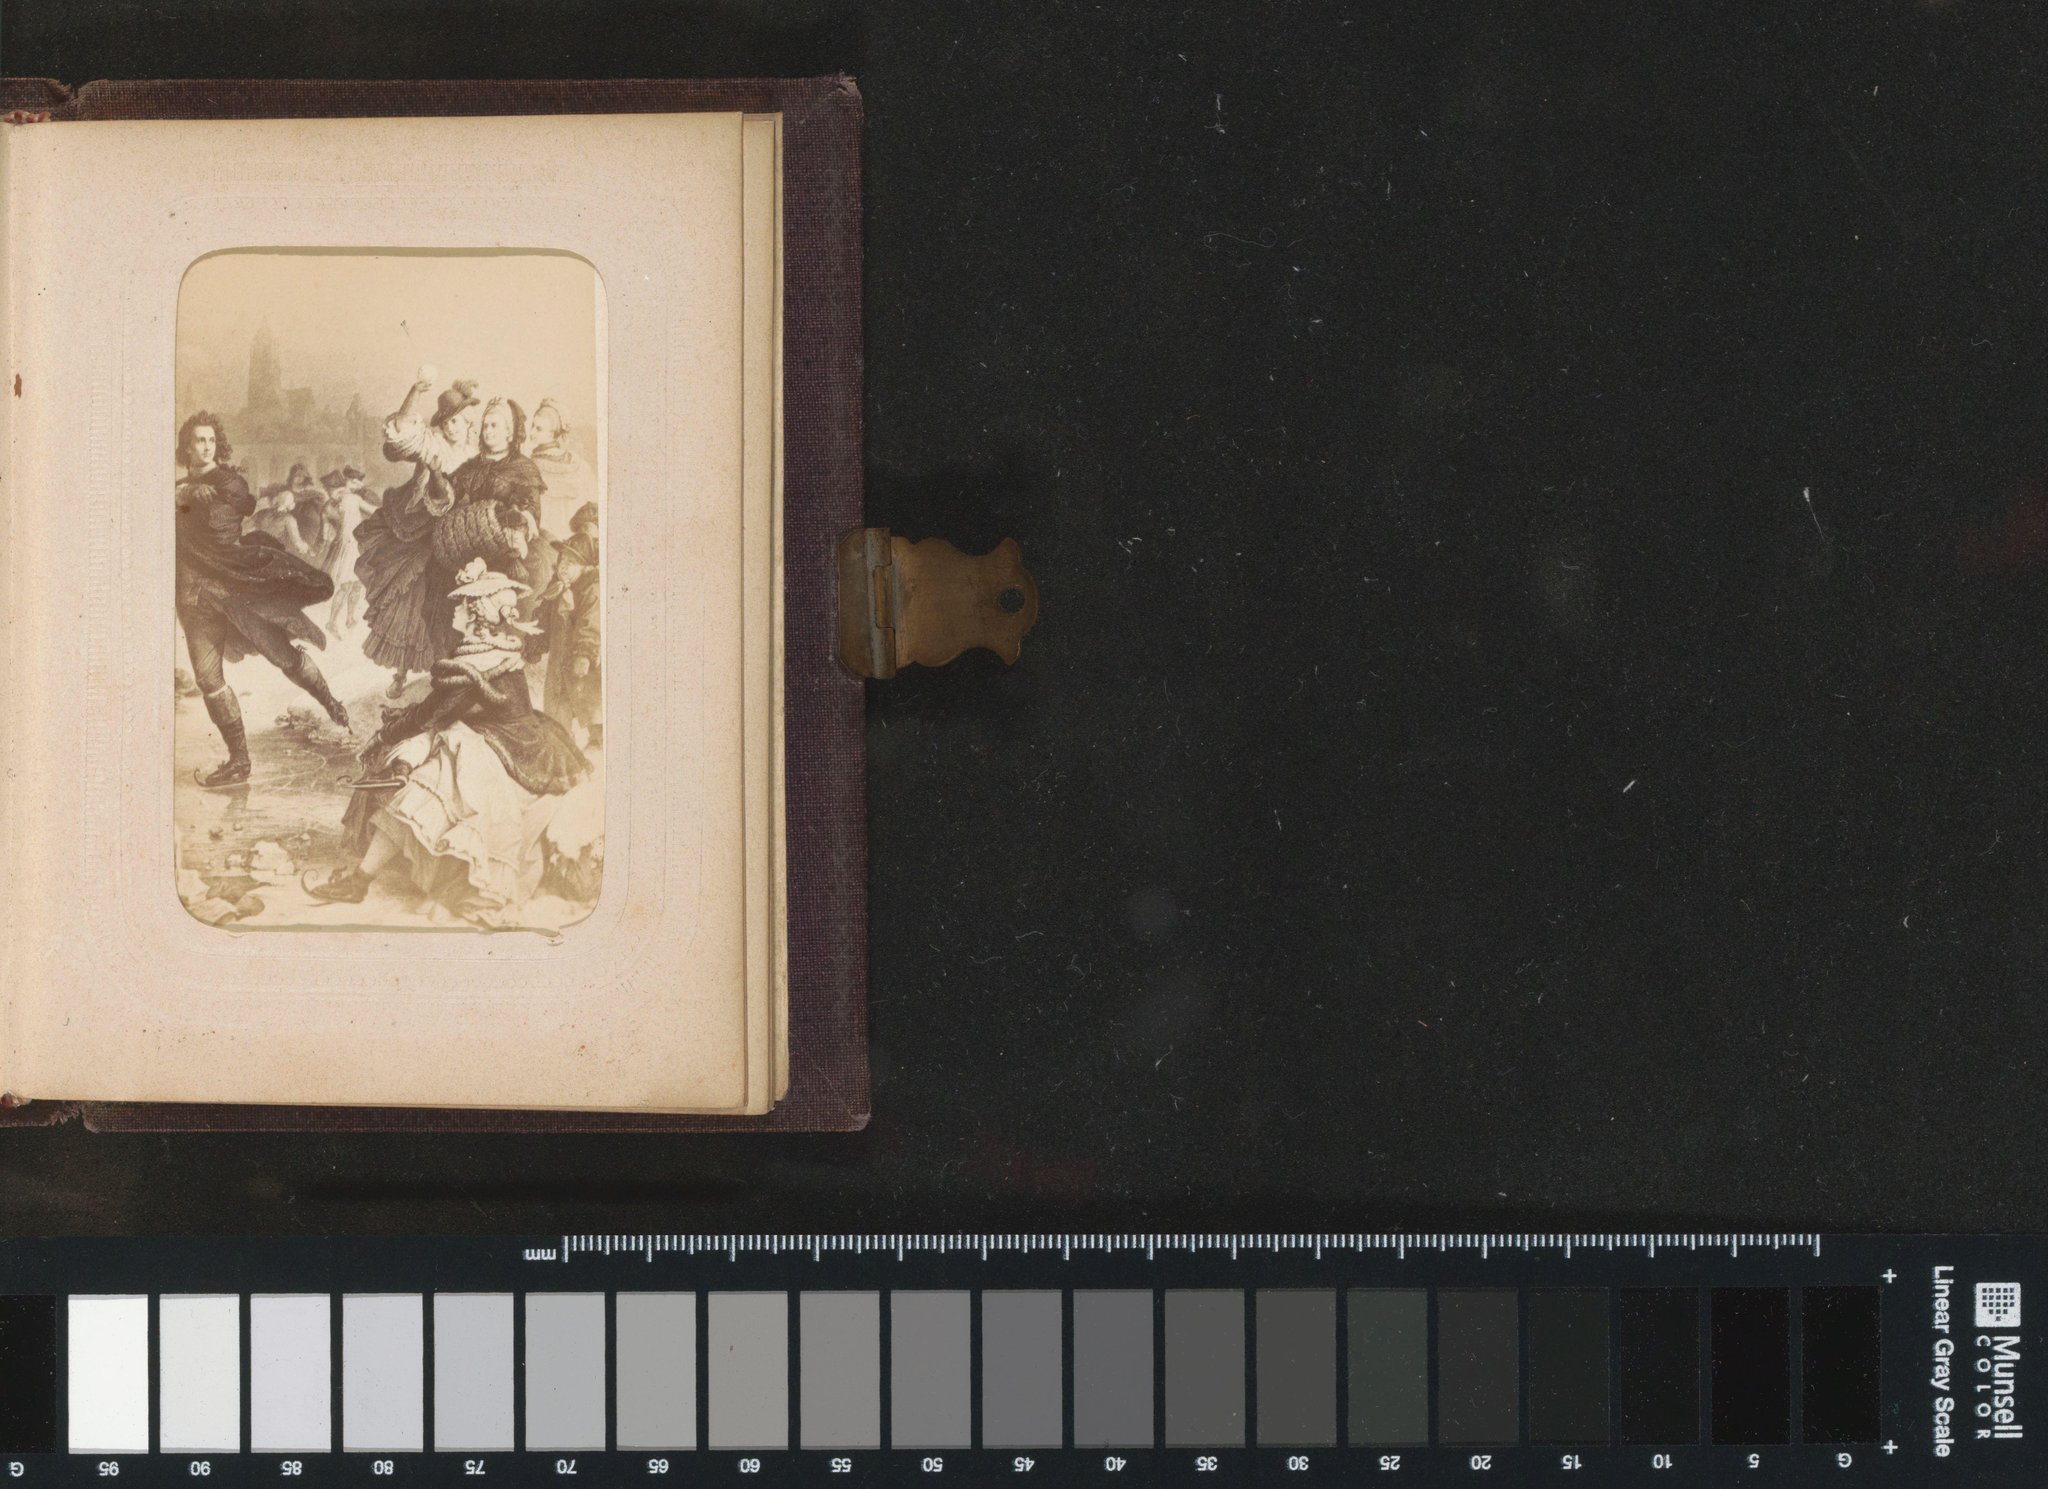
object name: photograph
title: Fotoreproductie van (vermoedelijk) een prent naar werk van W. von Kaulbach: Goethe in Frankfurt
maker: andries jager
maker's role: publisher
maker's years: 1825-1905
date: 1860-1890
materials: cardboard, paper, photographic support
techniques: albumen print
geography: amsterdam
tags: draughtsman, johann wolfgang von goethe, adult woman, adult man, skates (winter sports)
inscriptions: address: ‘Water 110 Amsterdam’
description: Onderdeel van Fotoalbum met 16 cartes-de-visite van vrouwenfiguren uit het werk van J.W. von Goethe.